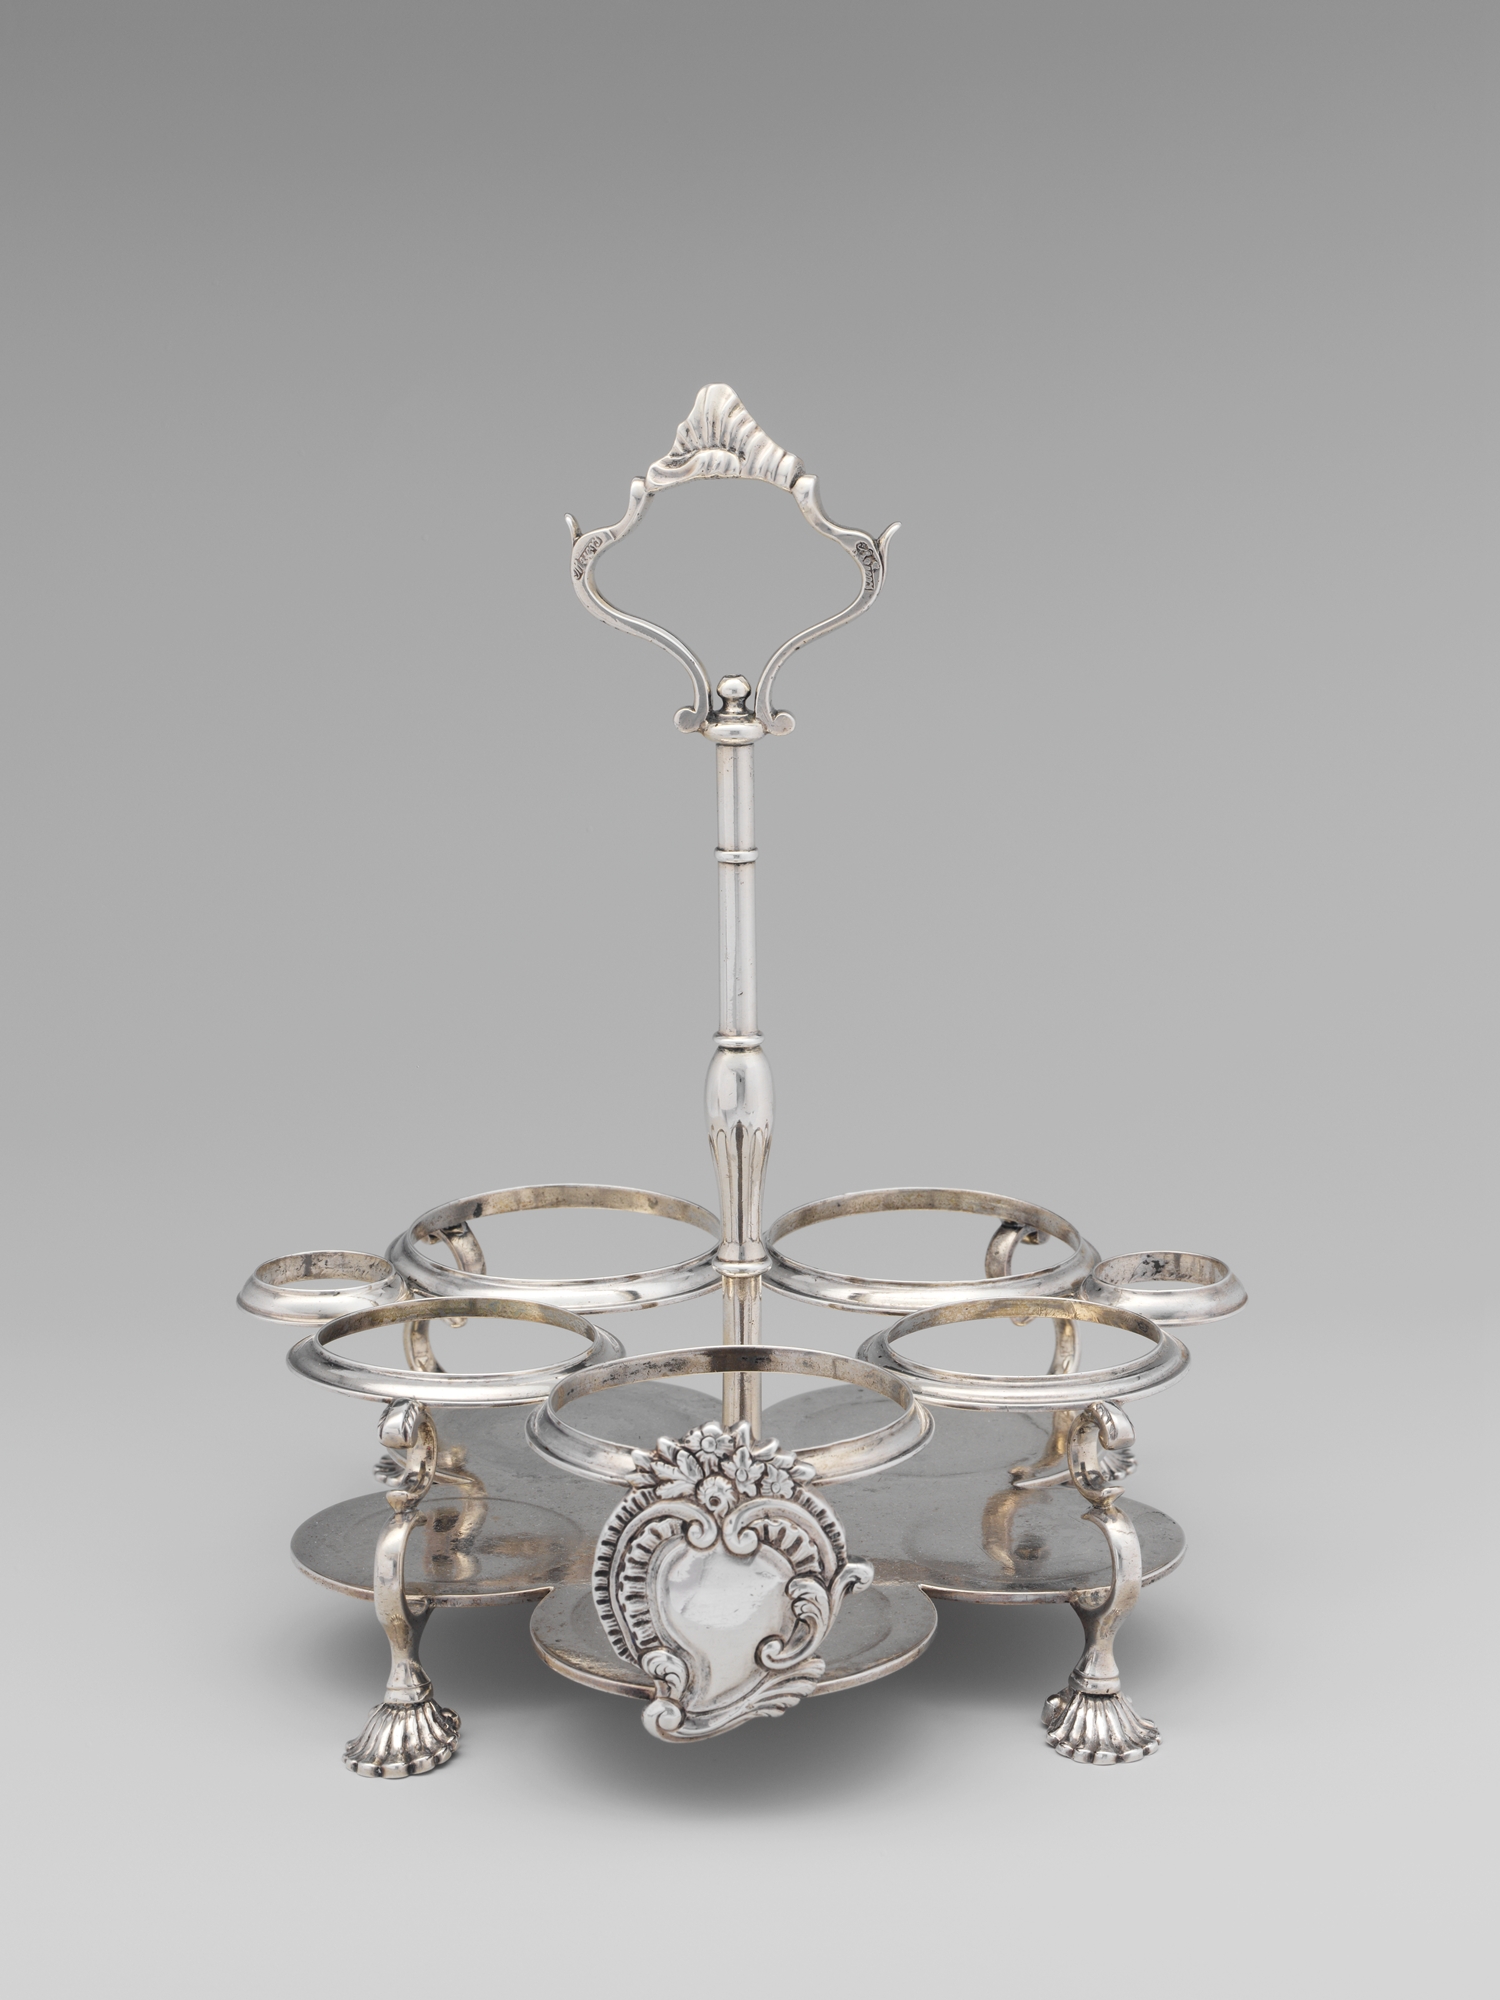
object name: cruet stand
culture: american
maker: myer myers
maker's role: maker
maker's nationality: american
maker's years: 1723-1795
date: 1765-1776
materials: silver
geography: united states